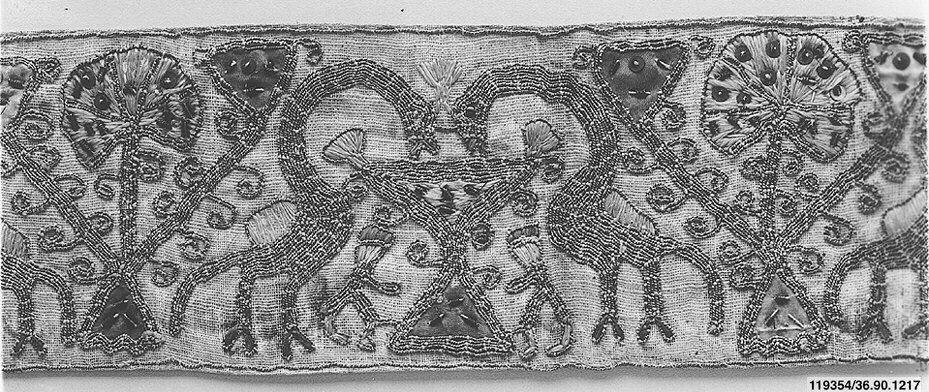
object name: piece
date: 1701-1800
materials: linen, metal thread, silk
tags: animals,trees